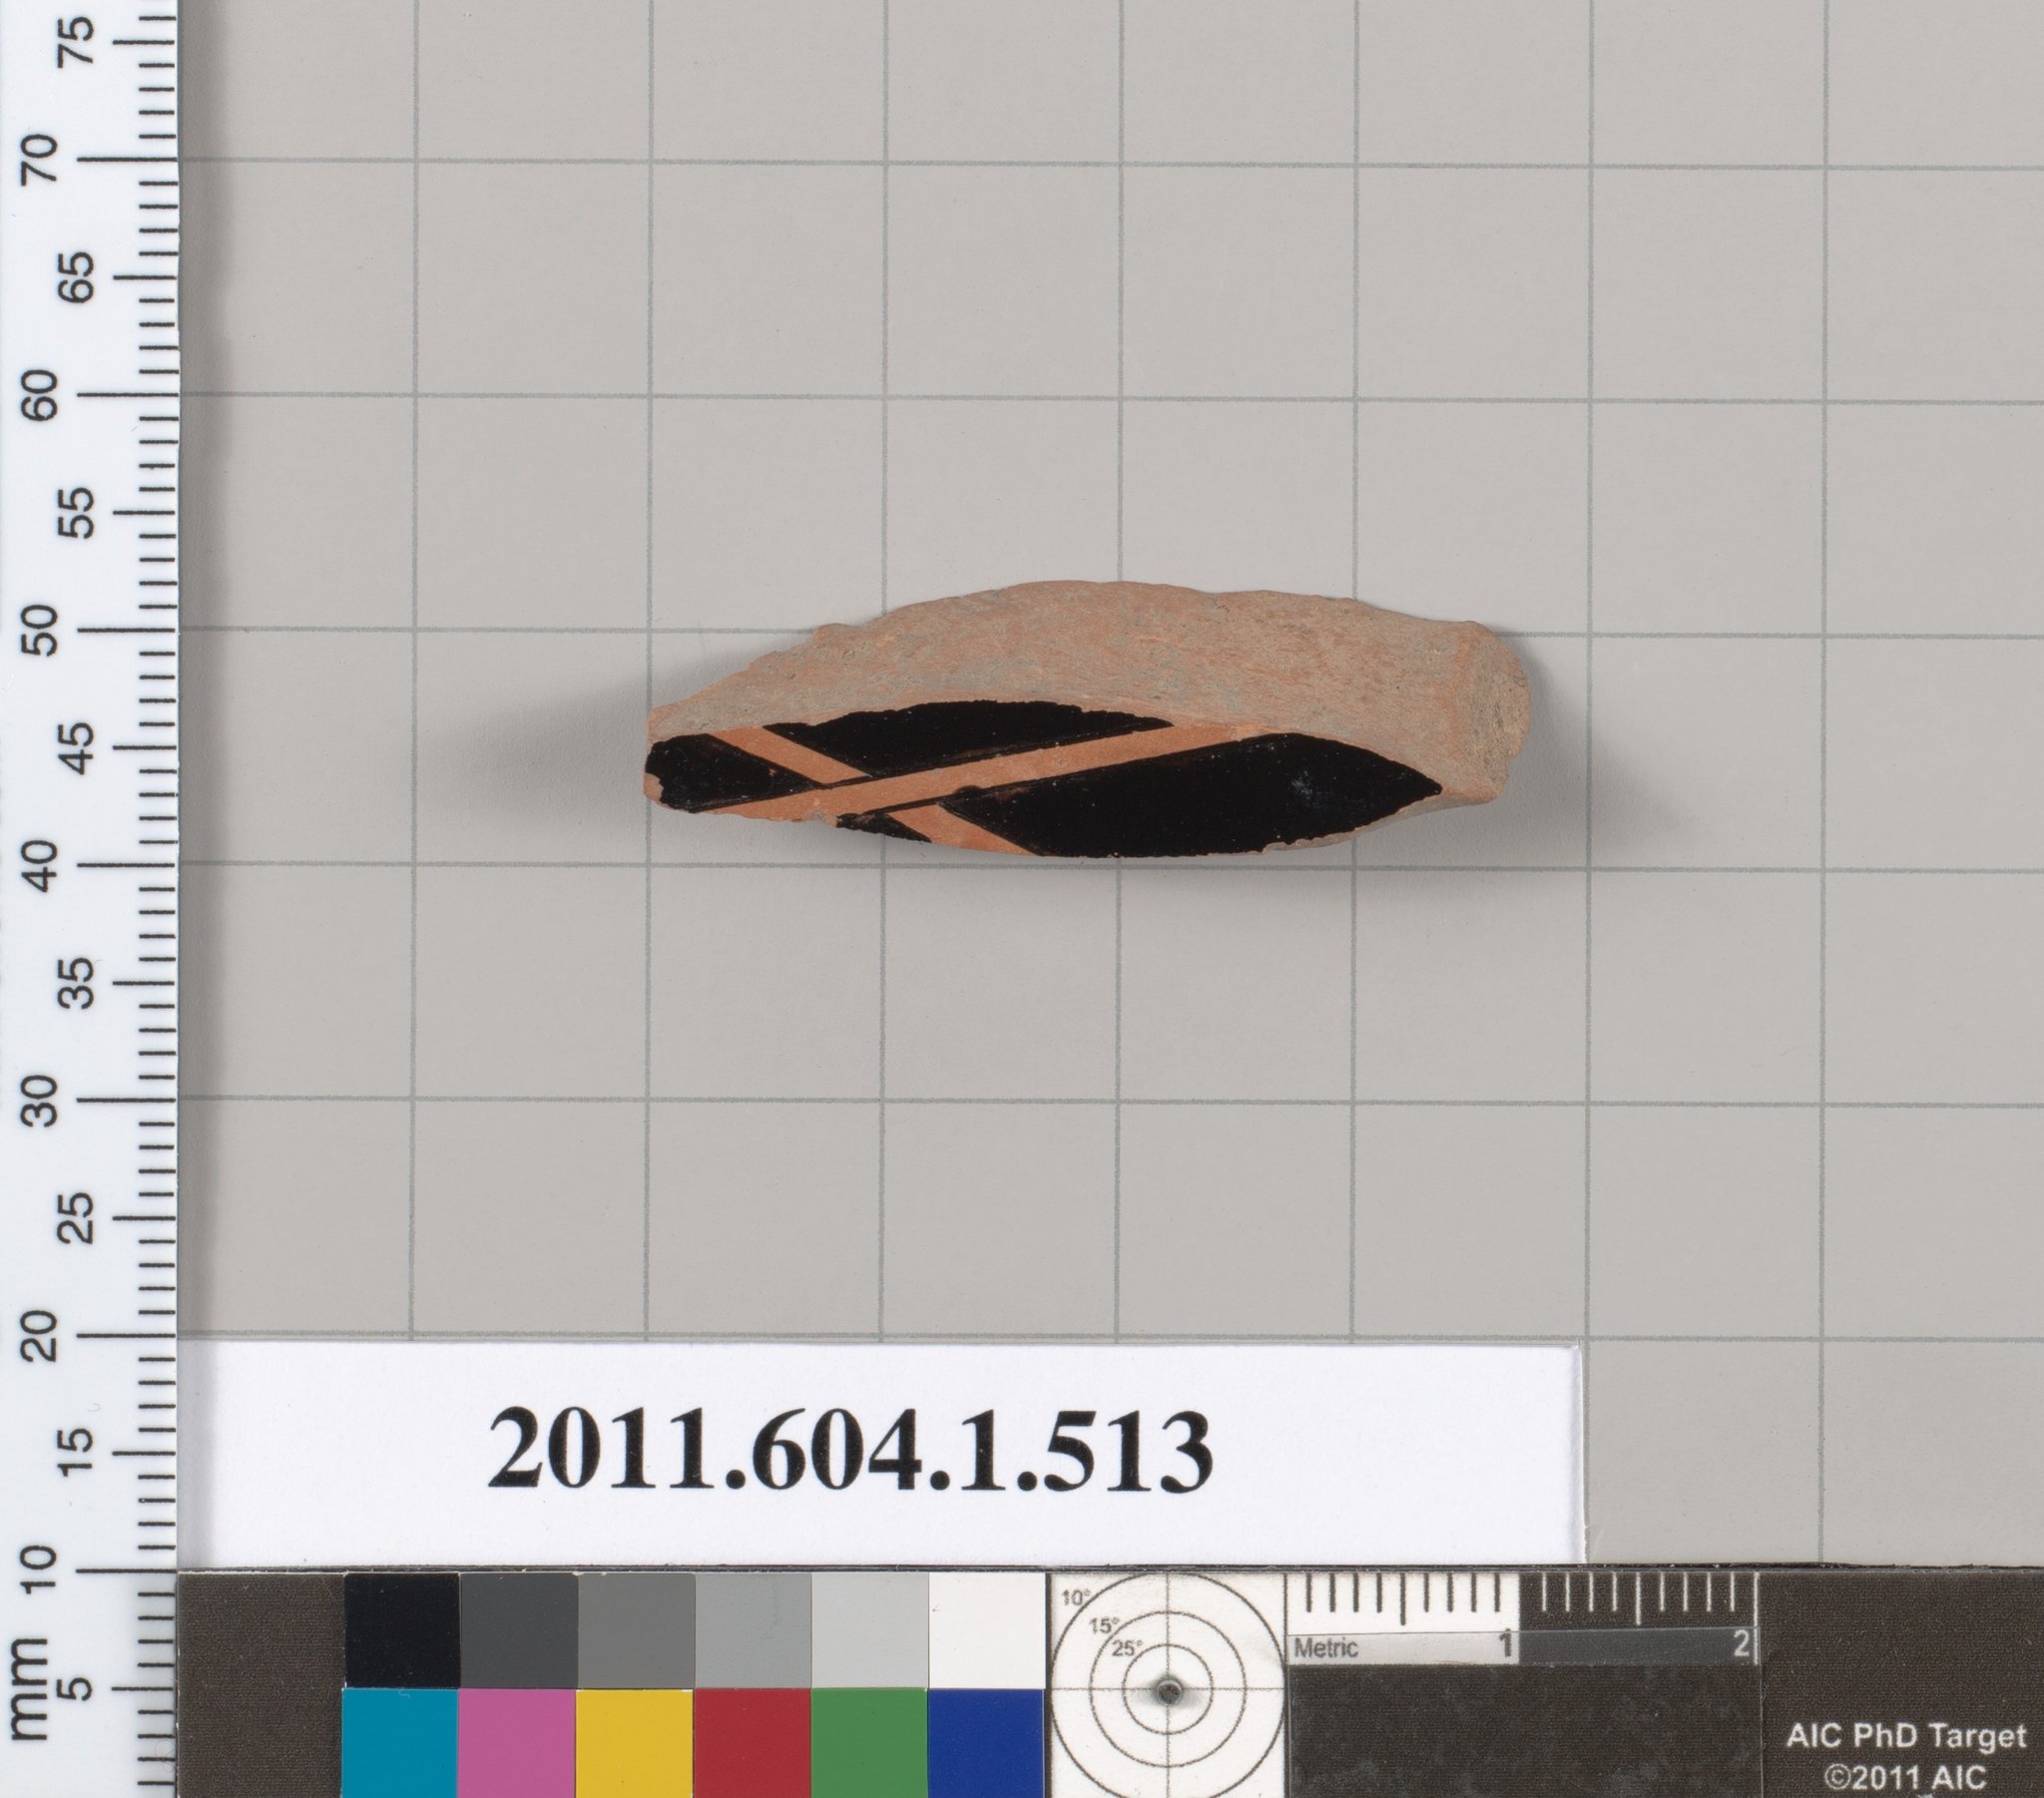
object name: kylix fragment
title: Terracotta fragment of a kylix (drinking cup)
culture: greek, attic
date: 500-476 BCE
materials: terracotta